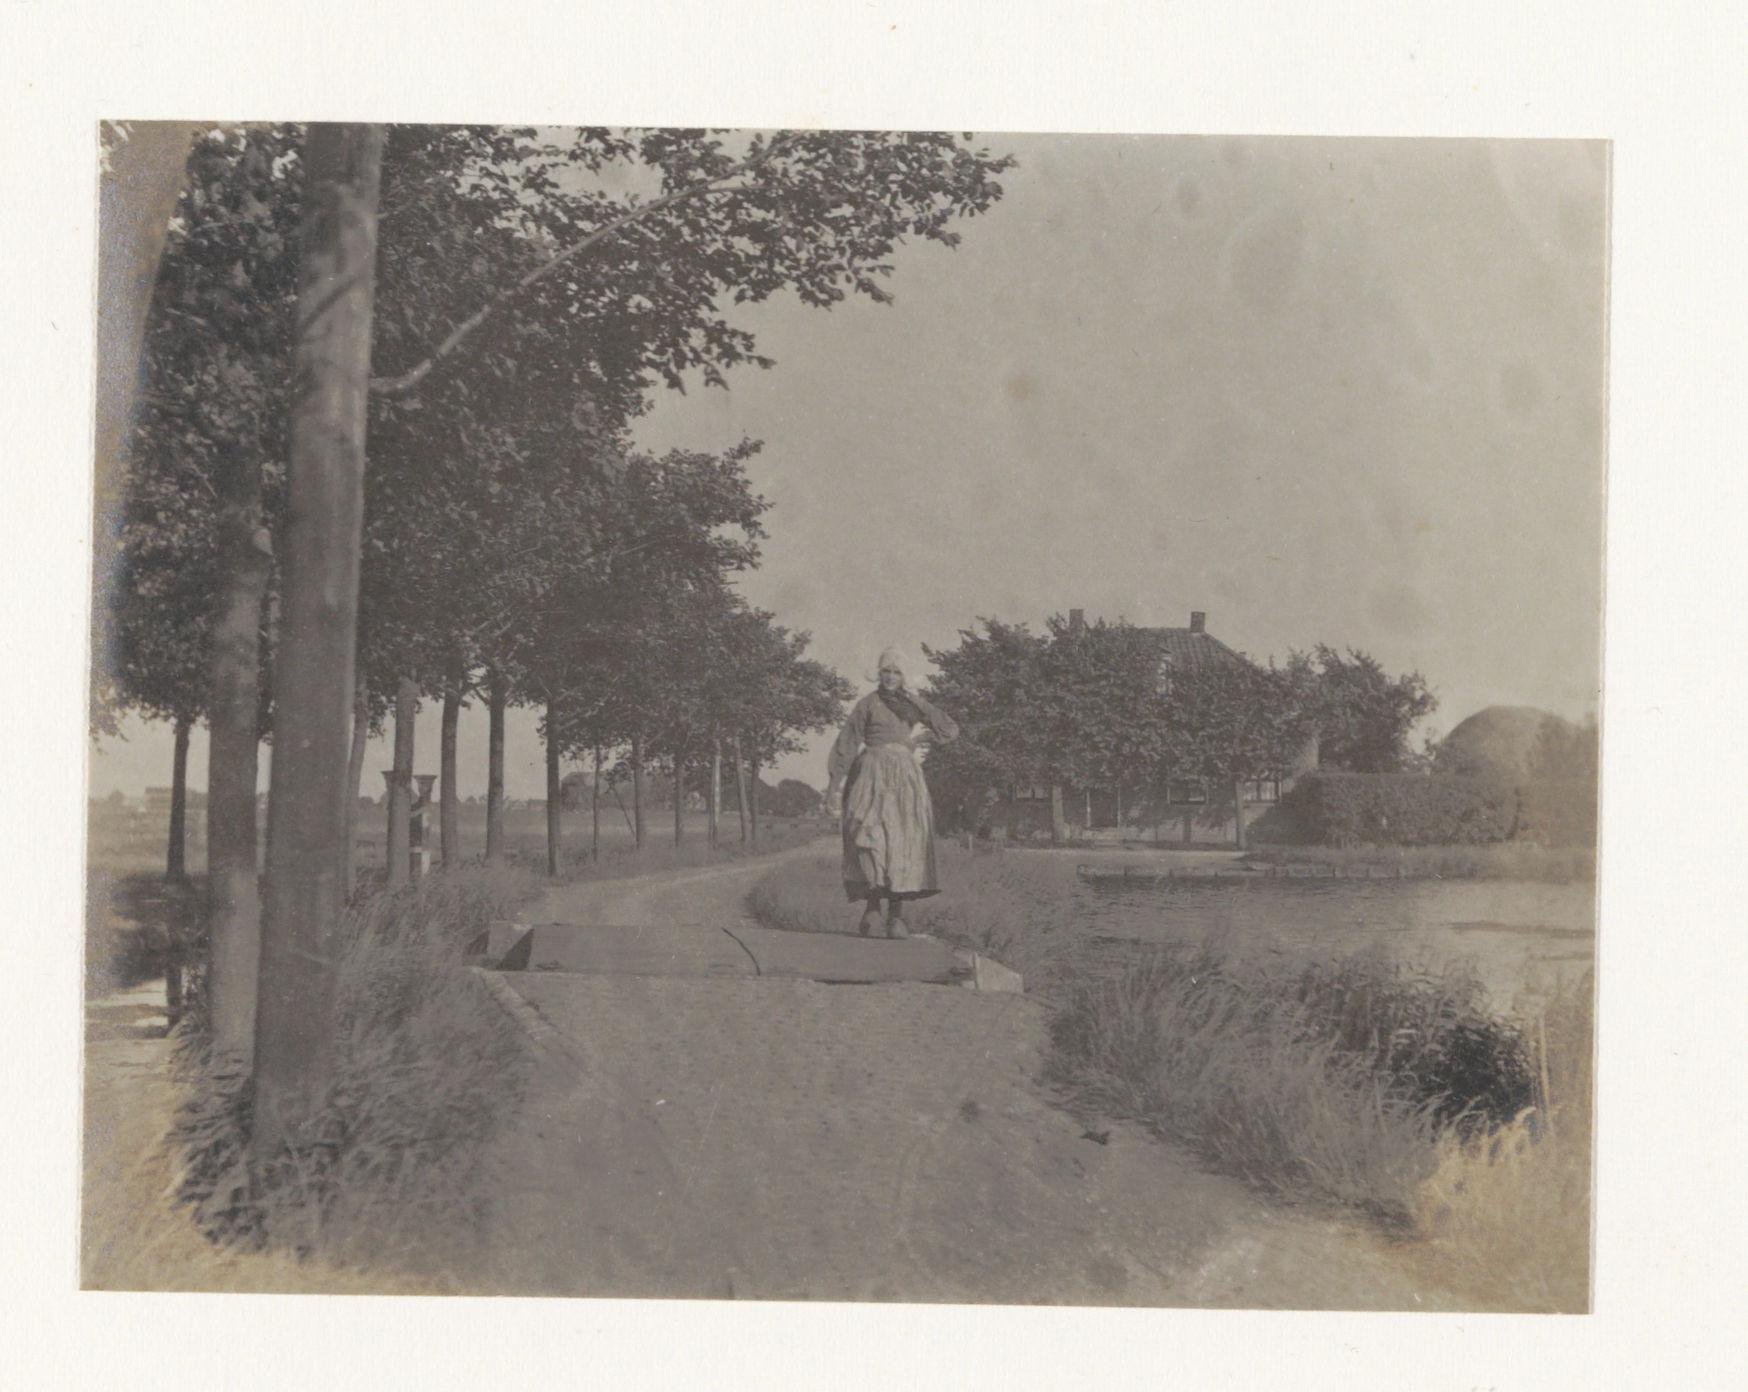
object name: photograph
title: Vrouw in klederdracht op een landweg, vermoedelijk in de buurt van Volendam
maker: george hidderley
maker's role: fotograaf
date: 1900-1910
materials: paper, photographic support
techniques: gelatin silver print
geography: volendam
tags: folk costume, regional costume (+ women's clothes), forest path or lane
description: Onderdeel van fotoalbum met opnames van Volendam, Dordrecht, Gorinchem en Woudrichem.